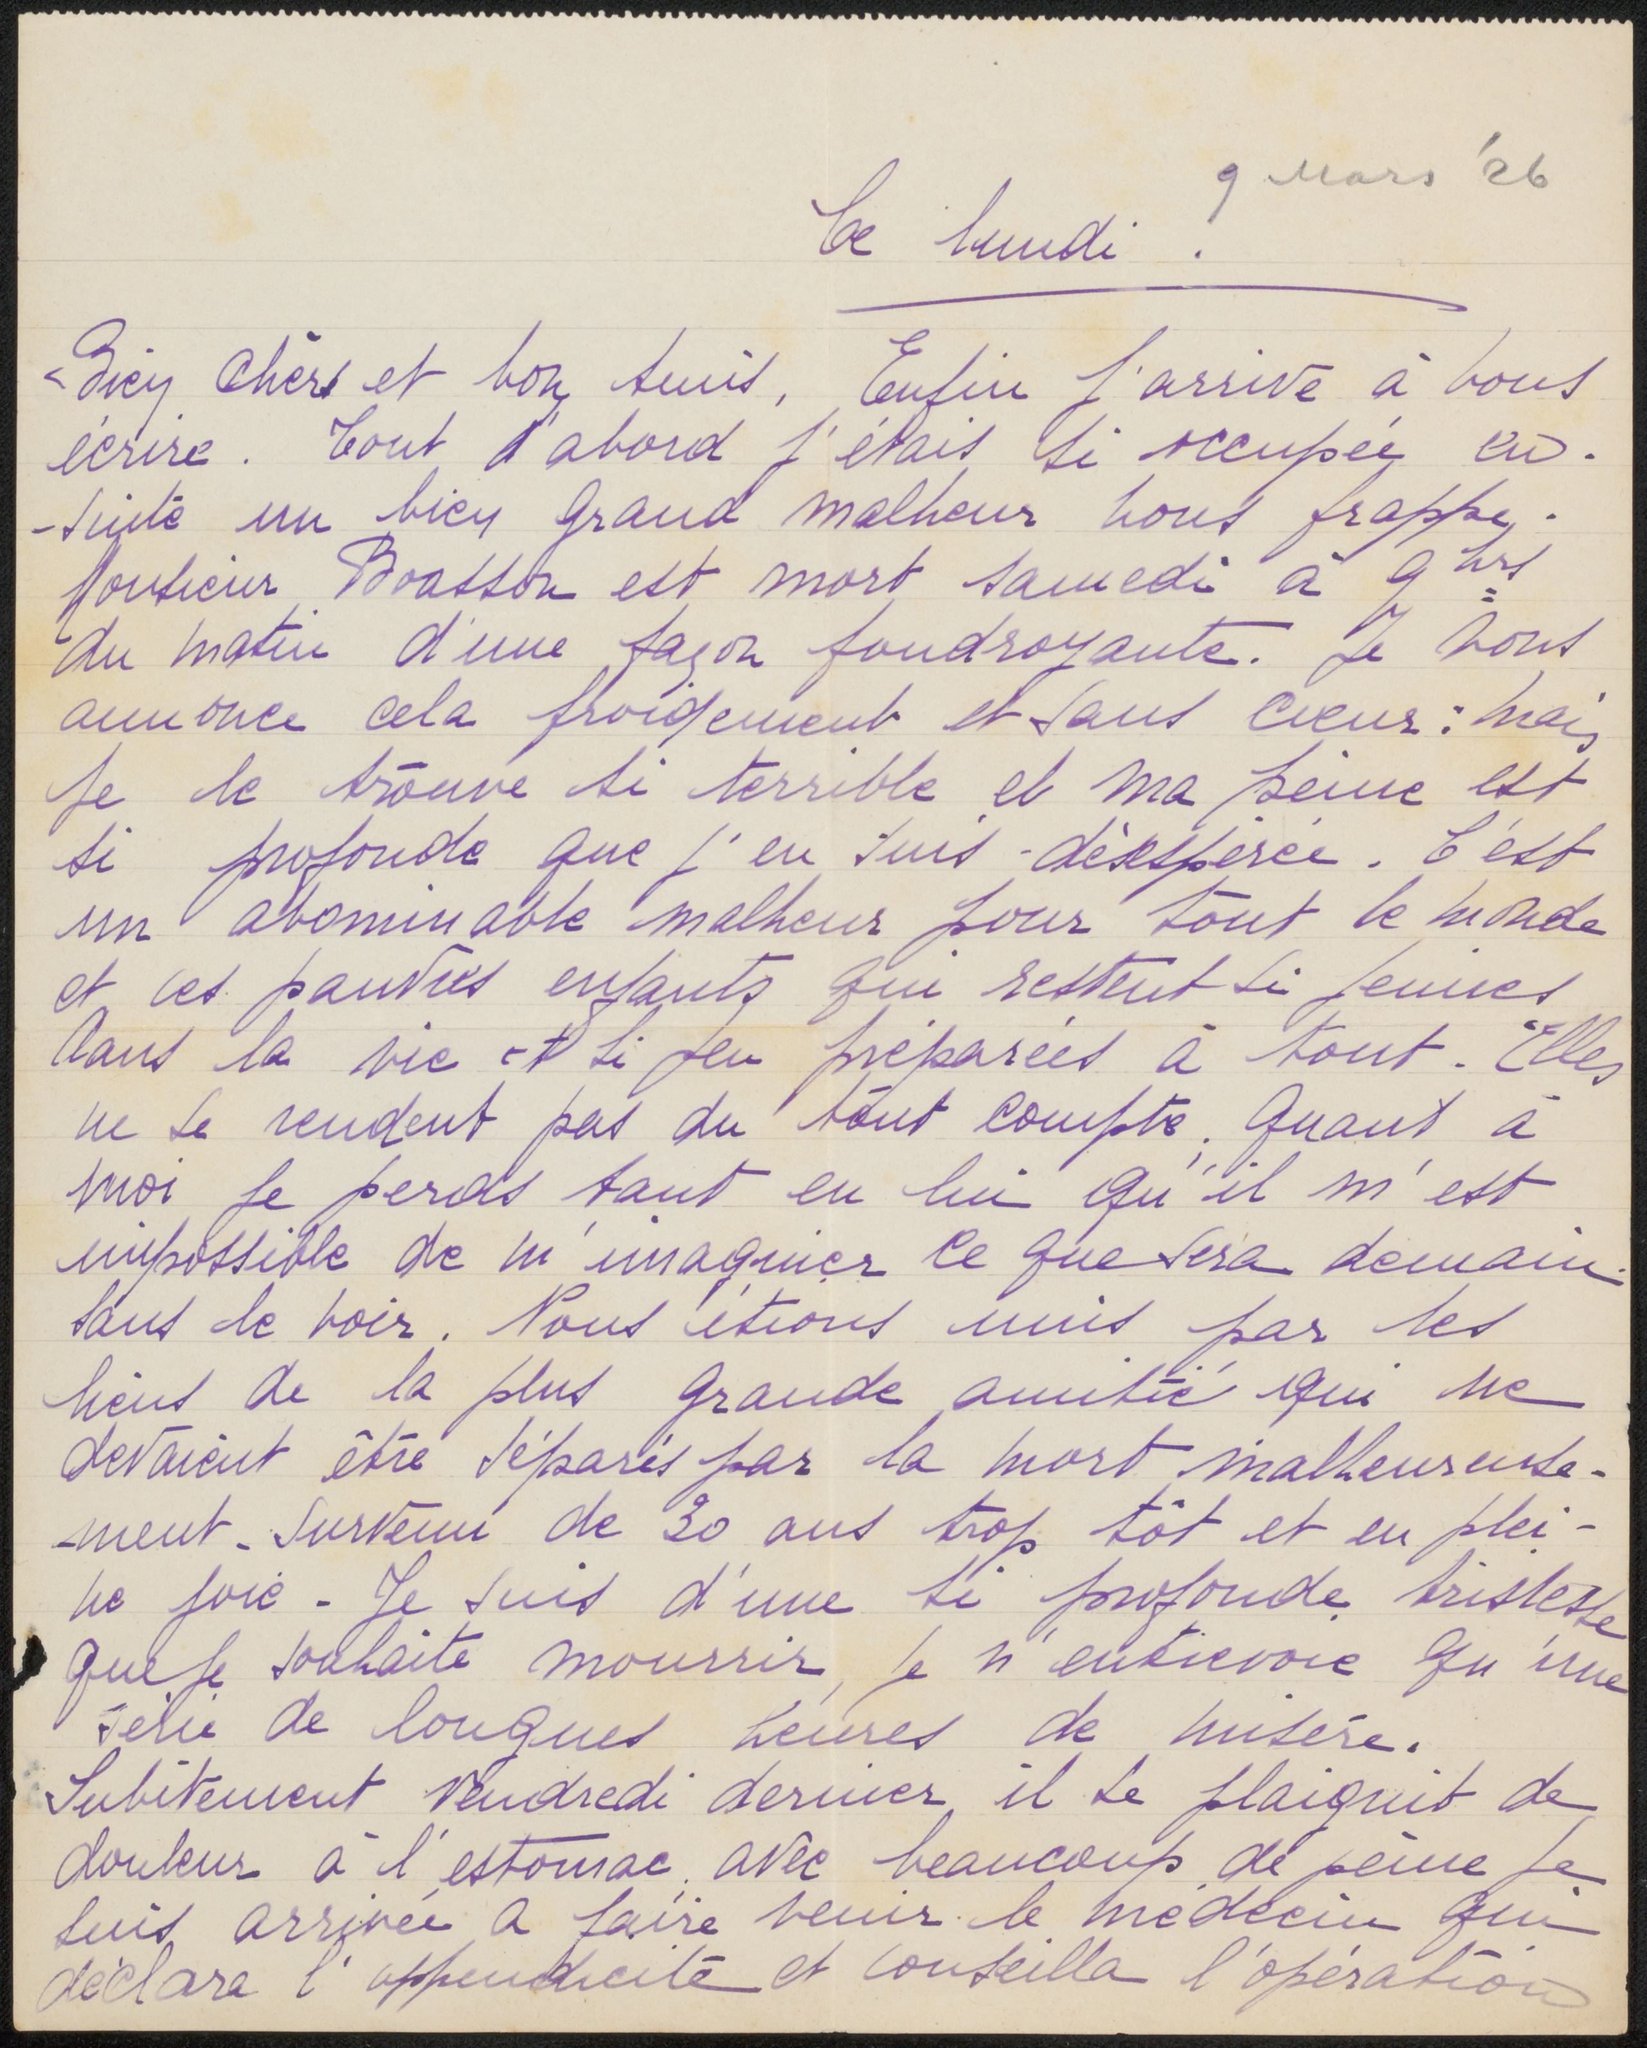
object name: letter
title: Brief aan Philip Zilcken en Henriette Wilhelmina van Baak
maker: rose imel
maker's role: draughtsman, painter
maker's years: 1901-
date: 1926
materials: ink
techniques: pen, writing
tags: paris, print maker, isodoor boasson, henriette wilhelmina van baak, the hague, painter, philip zilcken, passions, emotions, affections, diseases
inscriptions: collector's mark: ‘RPK’